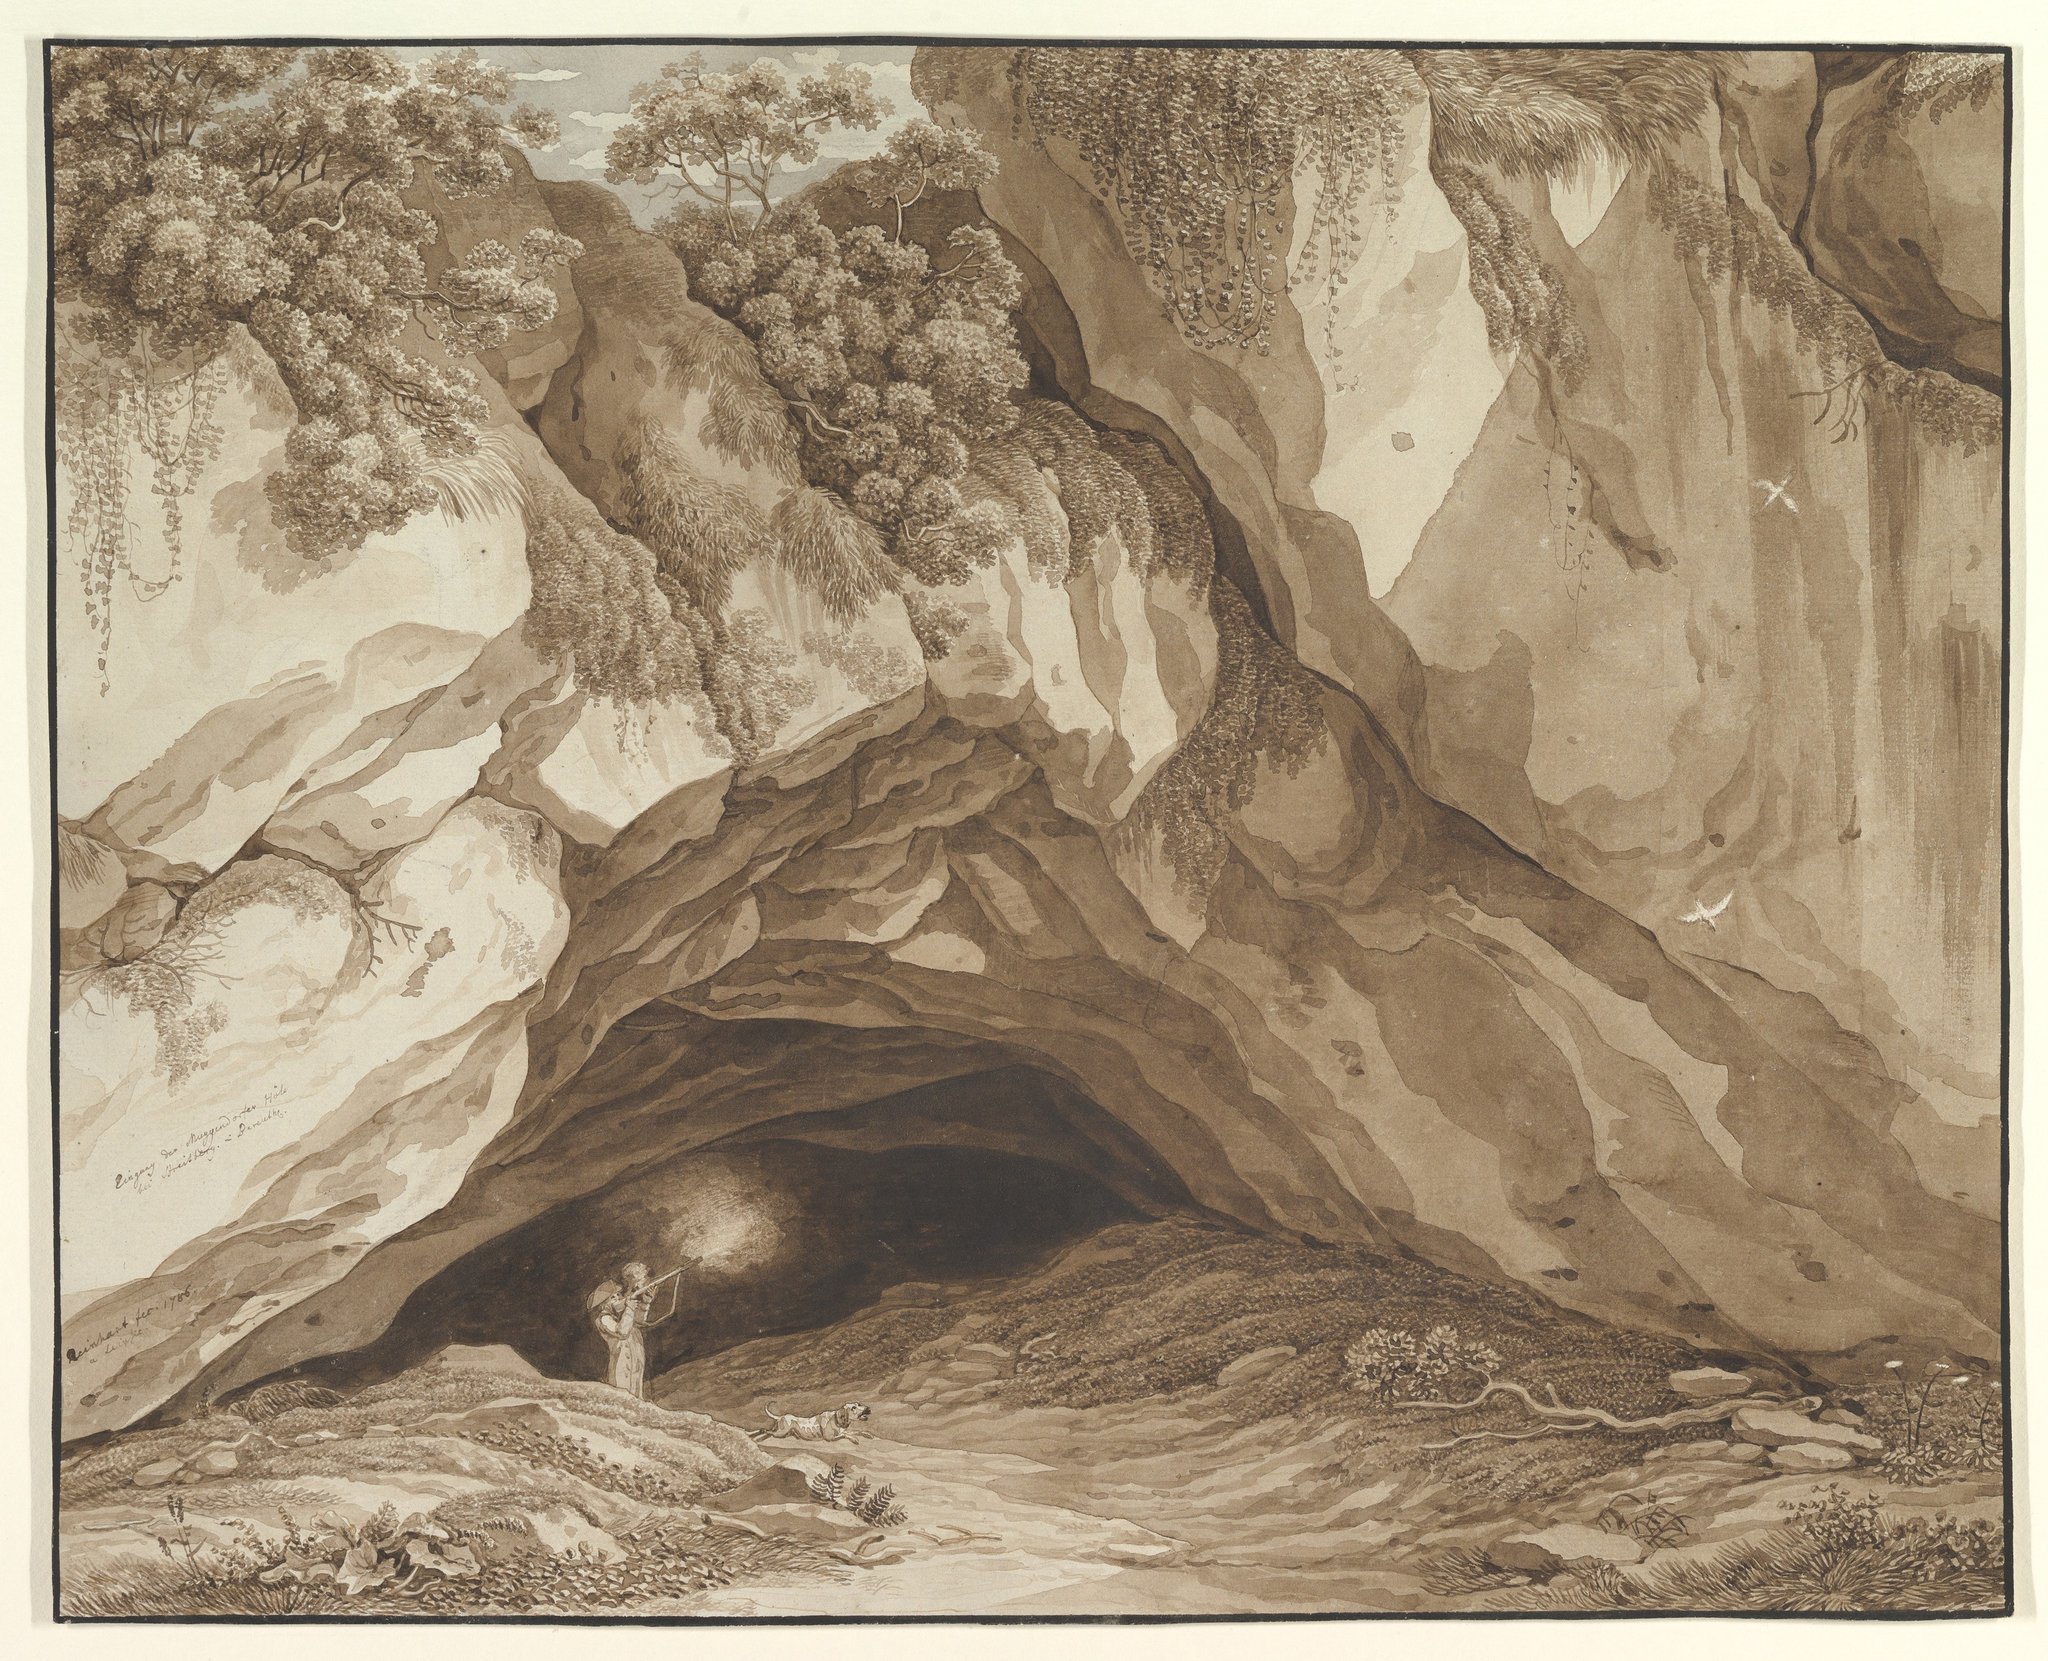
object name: drawing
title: Rocky Landscape with Hunters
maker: johann christian reinhart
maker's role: artist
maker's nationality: german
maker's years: 1761-1847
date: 1786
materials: ink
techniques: brush, pen, wash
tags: caves,landscapes,trees